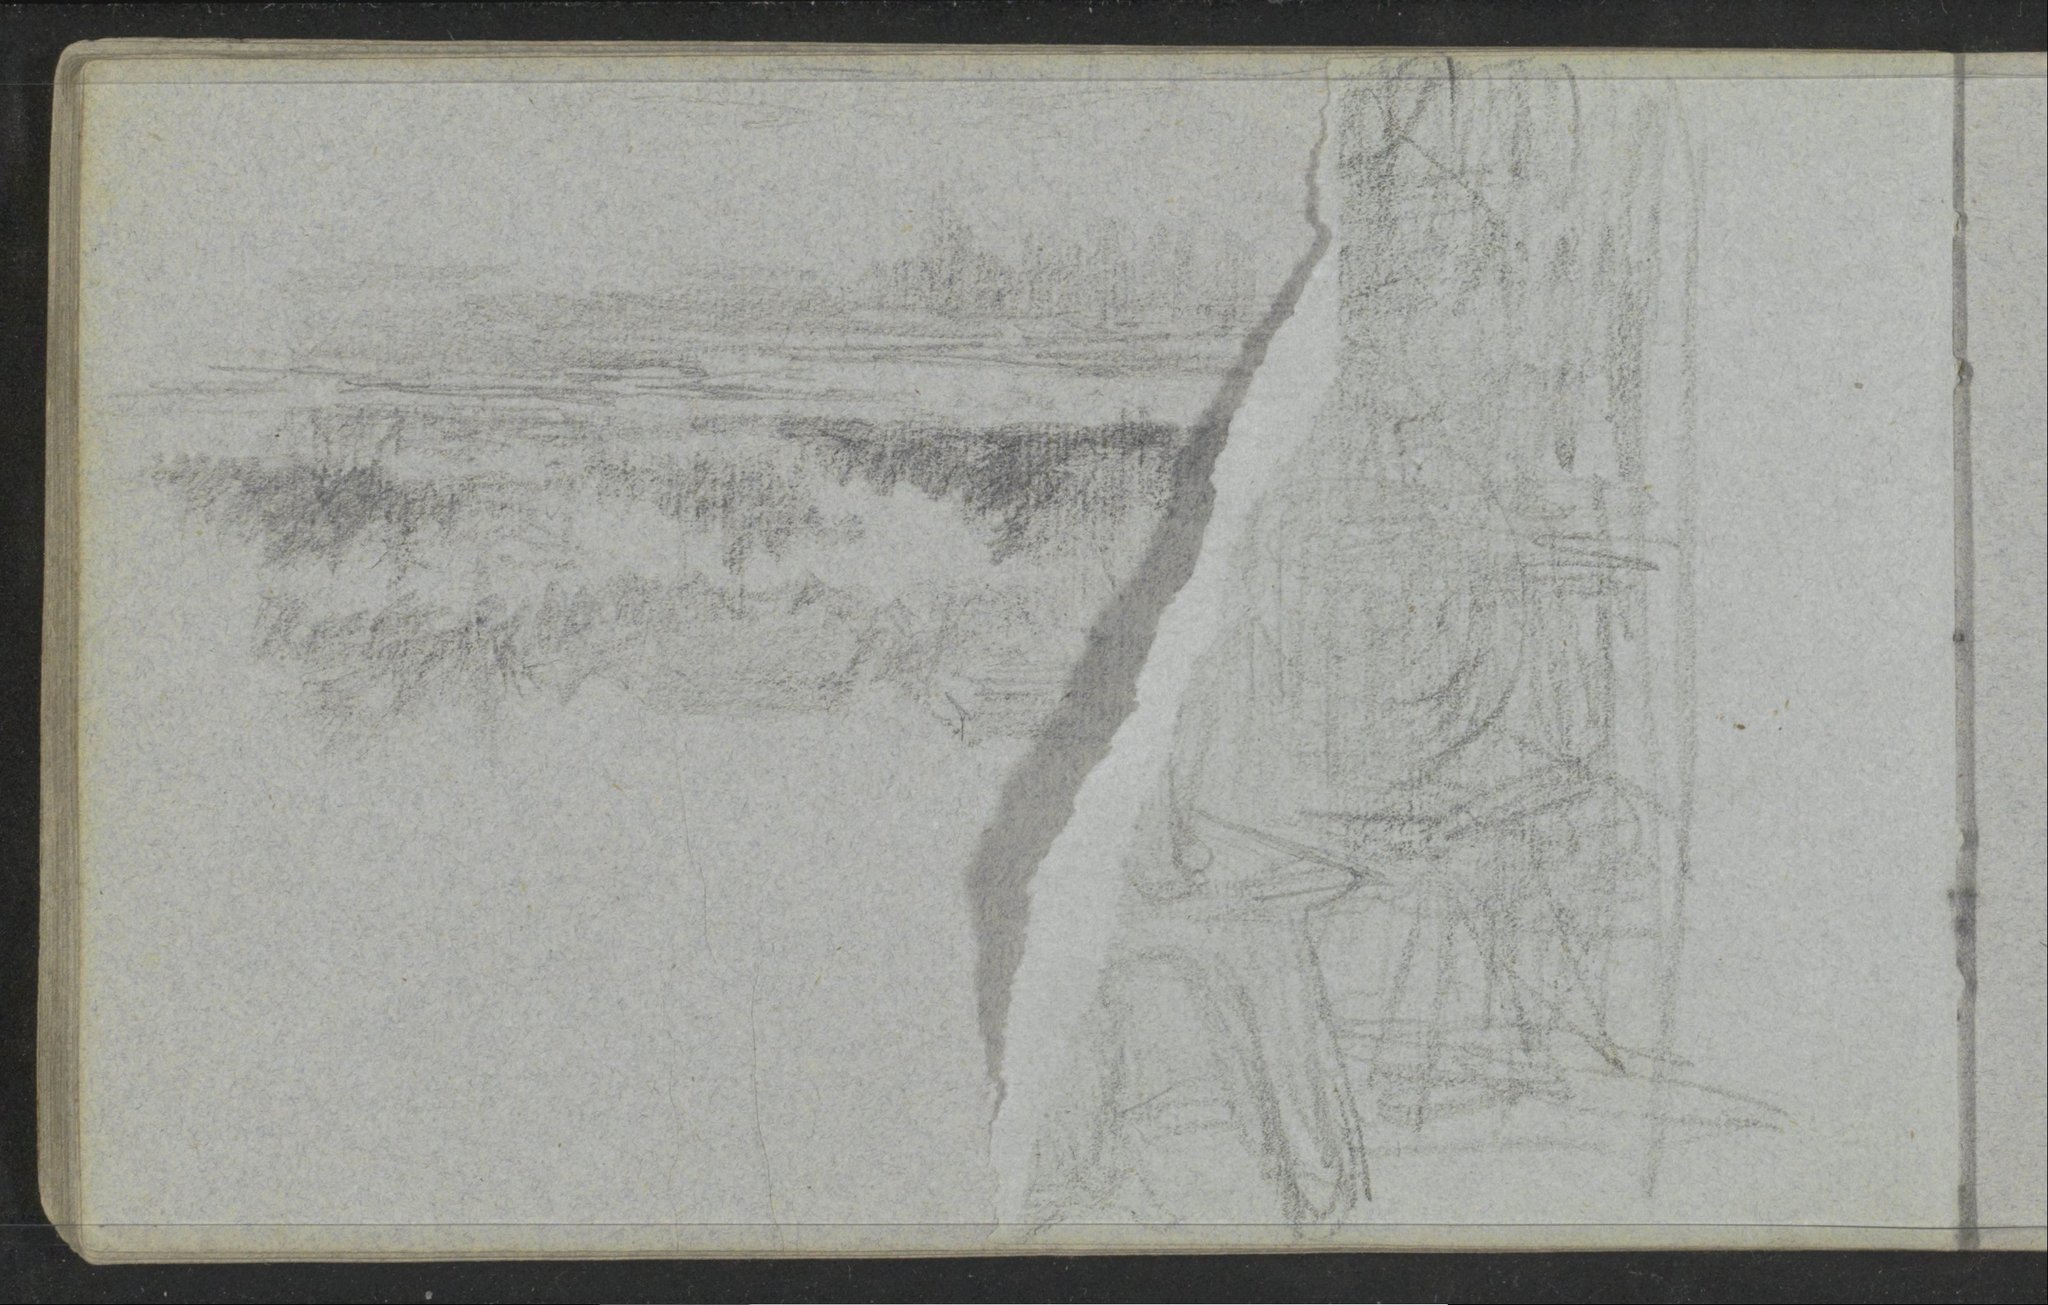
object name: sketchbook leaf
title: Studie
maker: matthijs maris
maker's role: draughtsman, painter, print maker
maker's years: 1839-1917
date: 1849-1917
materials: chalk, paper, pencil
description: Blad 25 verso uit een schetsboek met 35 bladen.